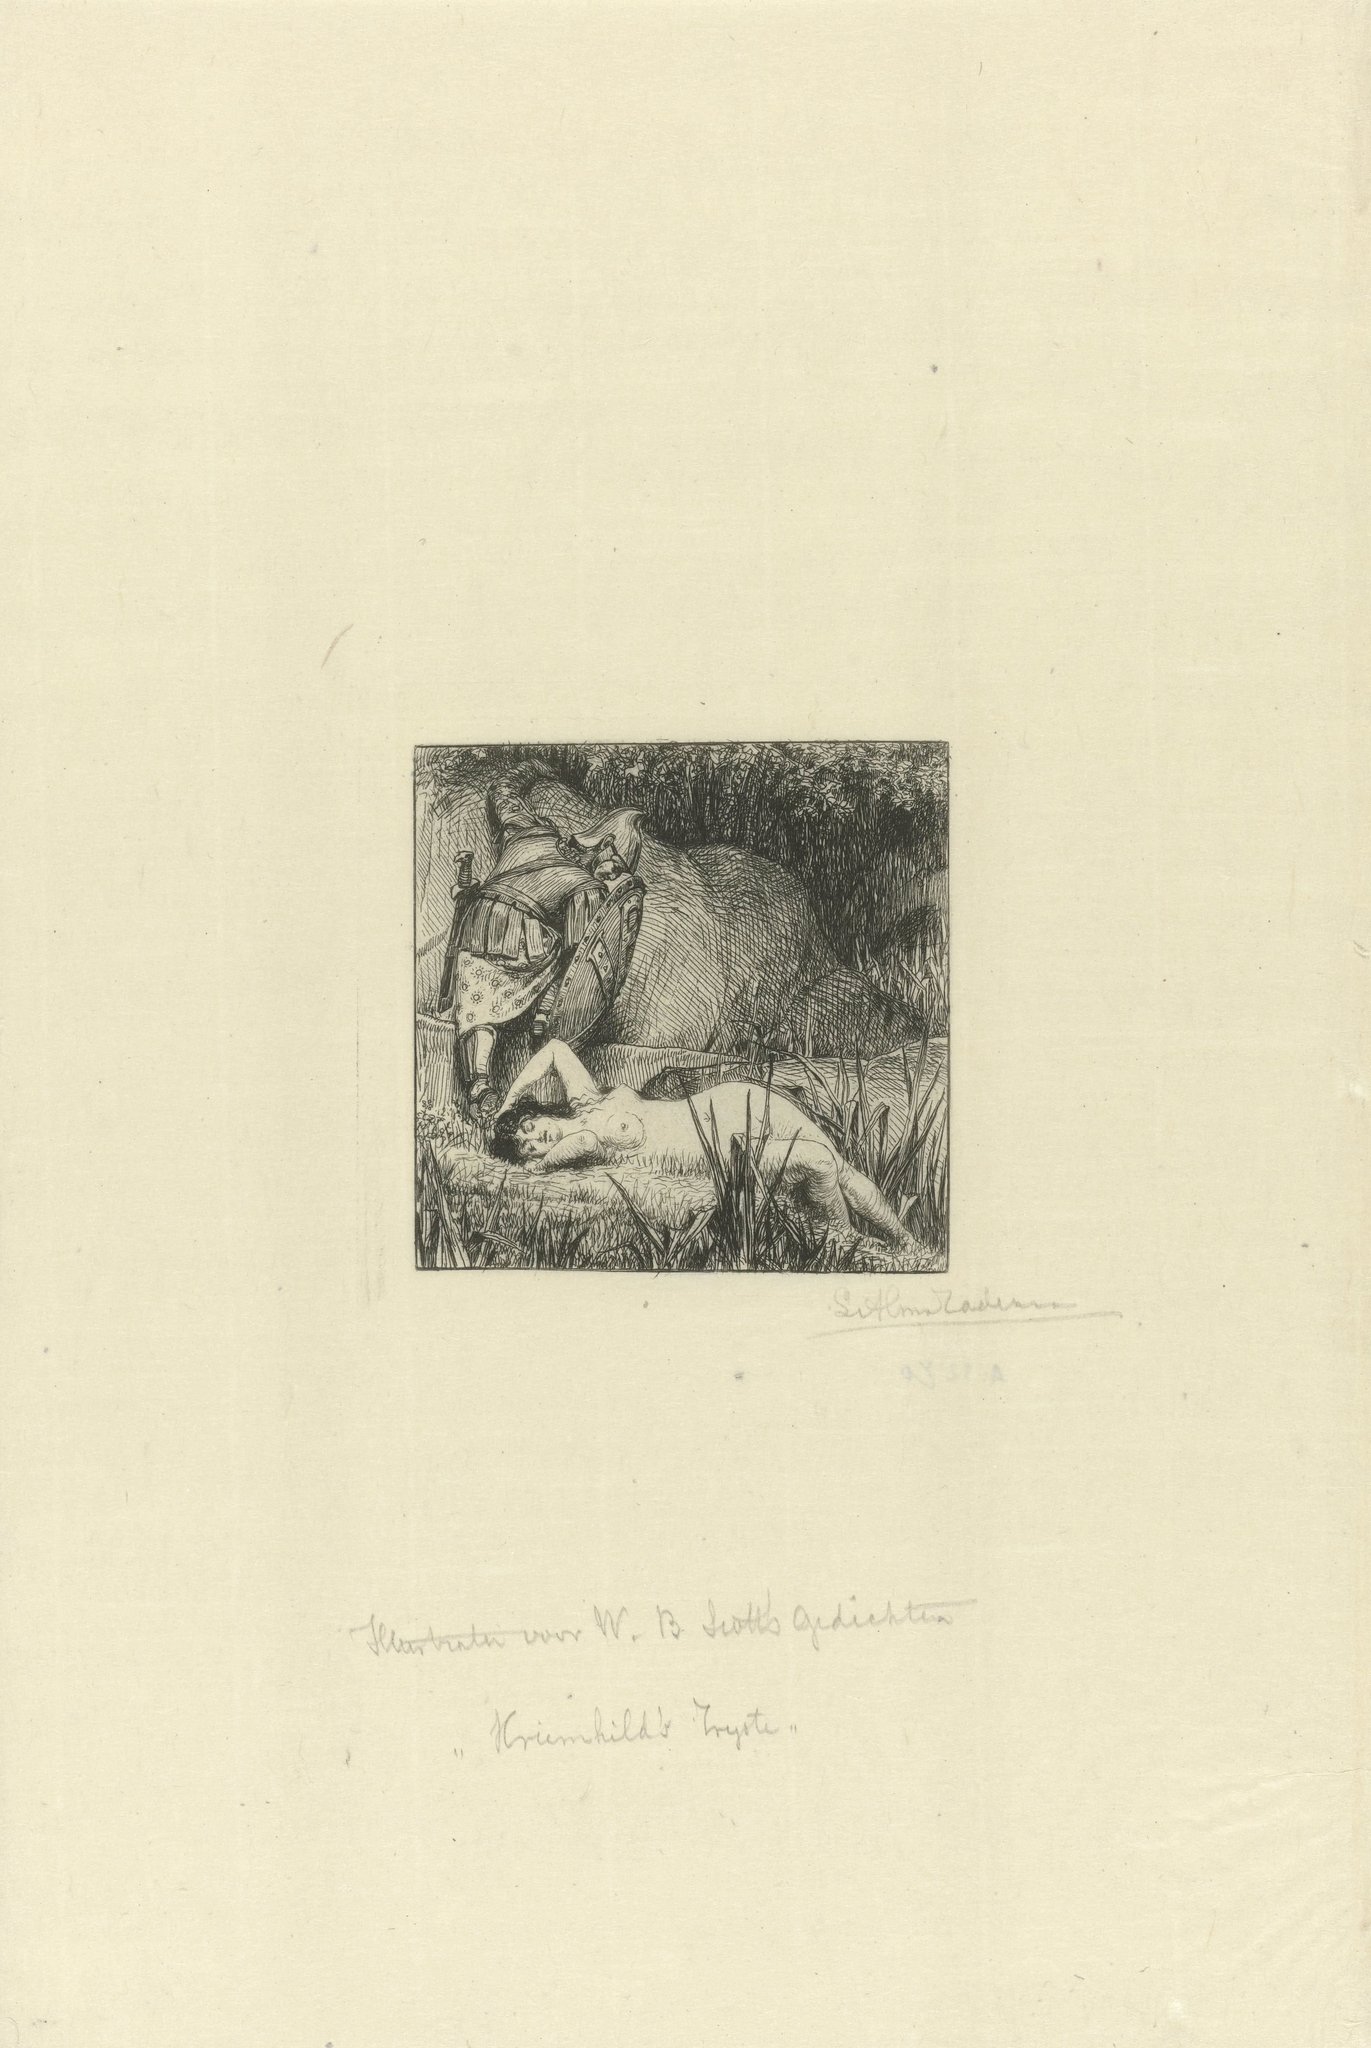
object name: book illustration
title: Naakte vrouw en een geharnaste ridder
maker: lourens alma tadema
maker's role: draughtsman, print maker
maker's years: 1836-1912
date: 1875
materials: paper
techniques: etching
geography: london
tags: woman (showing herself) undressed, quasi-nude, knight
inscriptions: signature: ‘L Alma Tadema’, inscription: ‘Illustratie voor W.B. Scott's gedichten "Kriemhild's Tryste"’, collector's mark: Lugt 2227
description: Een naakte vrouw ligt met gesloten ogen in het gras. Een geharnaste ridder sluipt omkijkend weg.